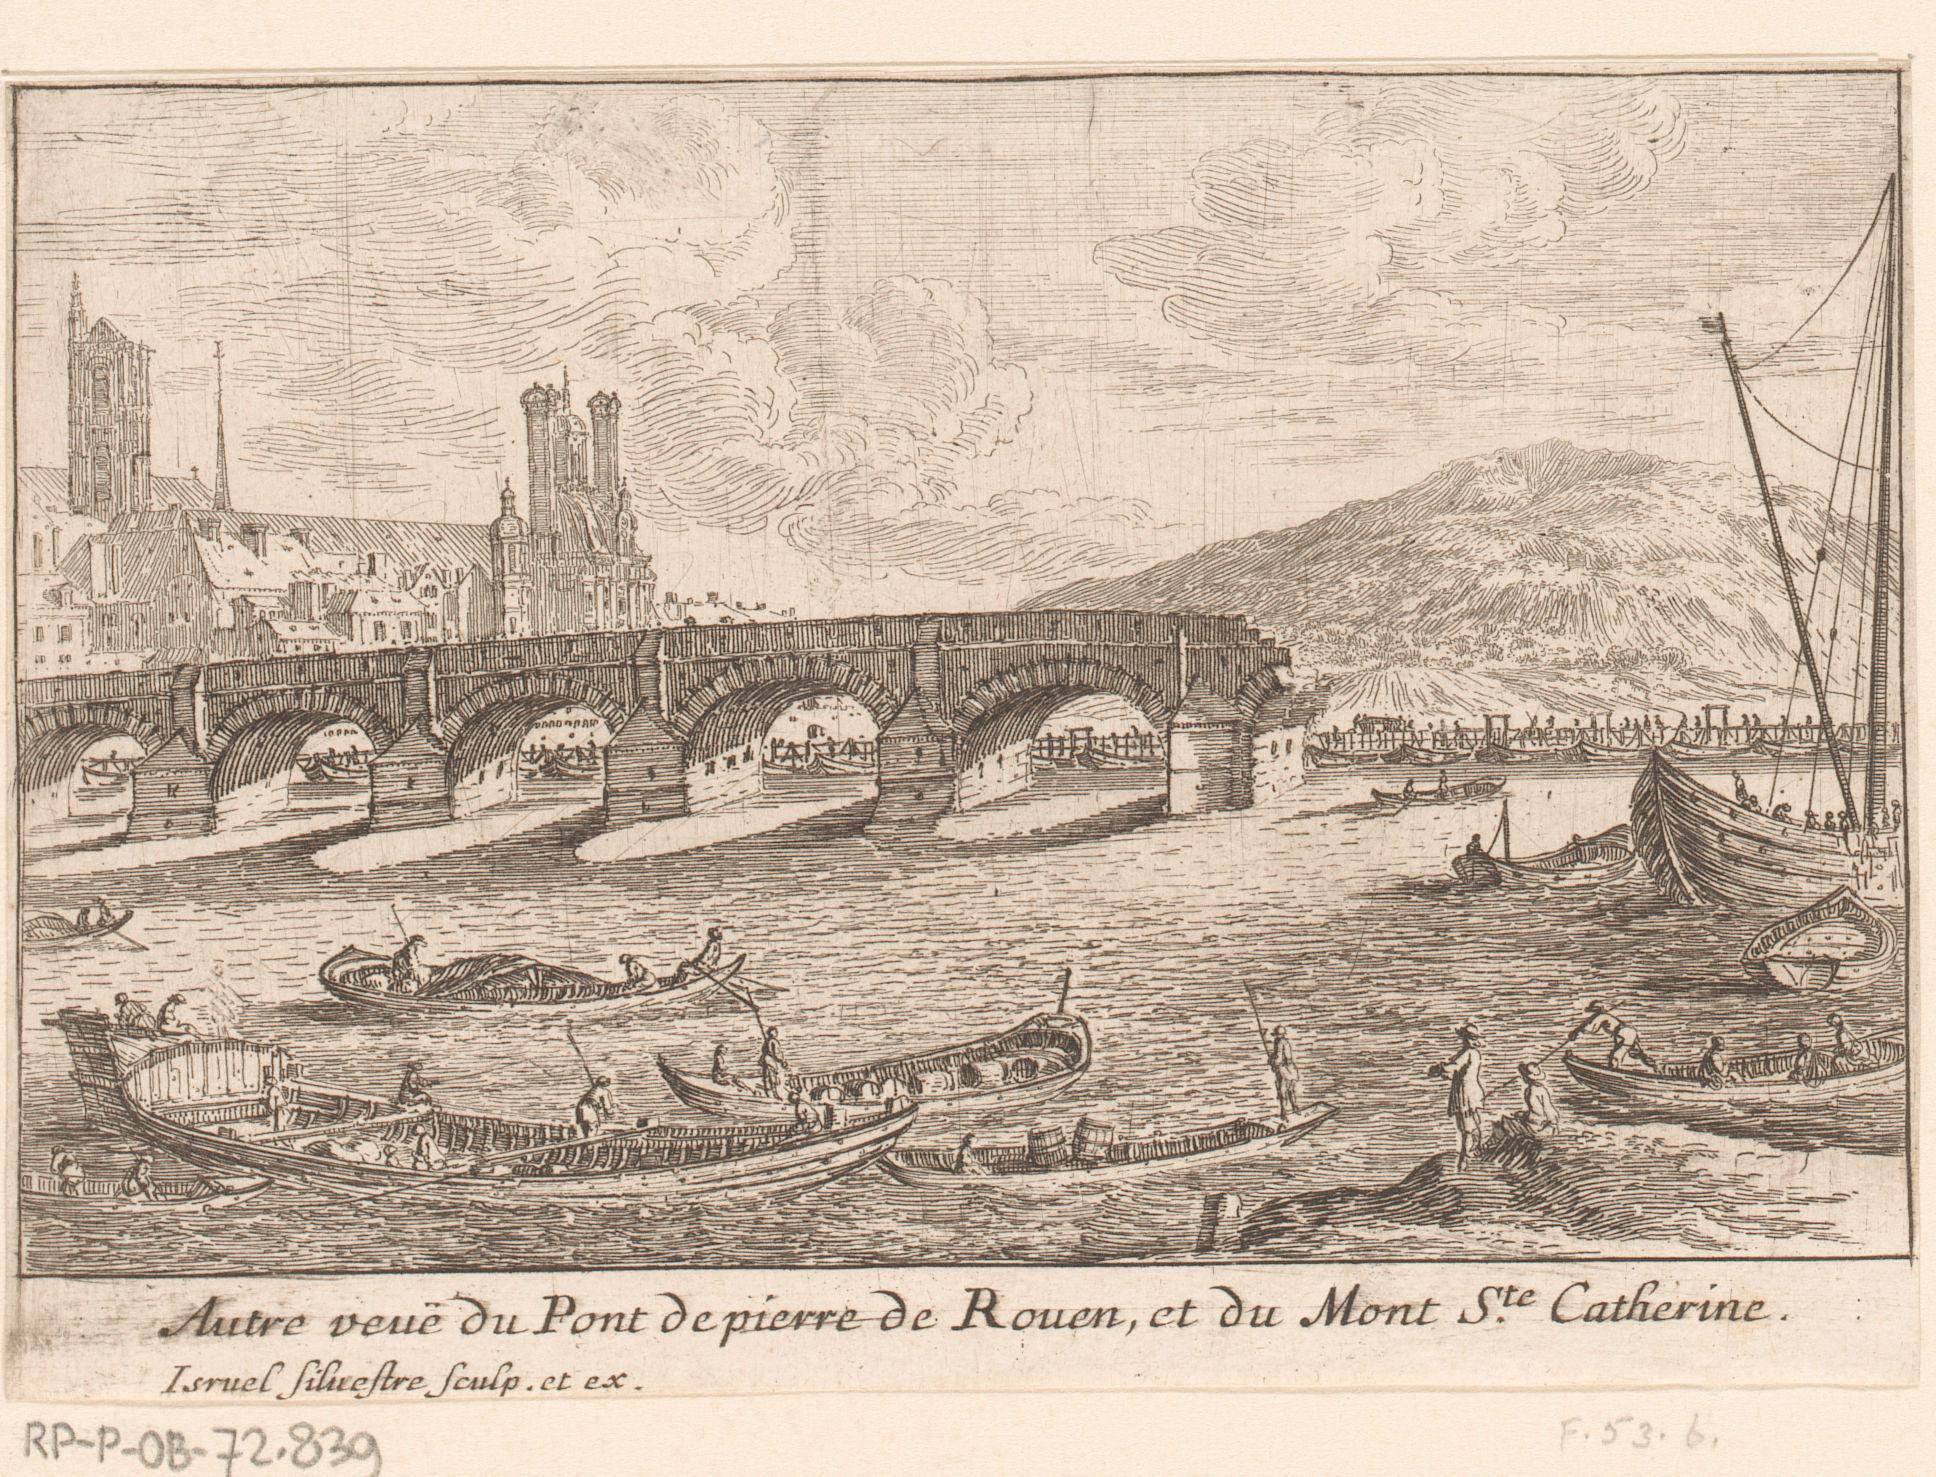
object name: print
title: Ander gezicht op de Pont de Pierre in Rouen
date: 1631-1691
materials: paper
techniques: etching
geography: france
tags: landscape with bridge, viaduct or aqueduct, boat propelled by man or animal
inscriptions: collector's mark: Lugt 240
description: Prent maakt deel uit van een genummerde serie van negen prenten, maar de nummers zijn afgesneden. Dit is vermoedelijk nummer 6.